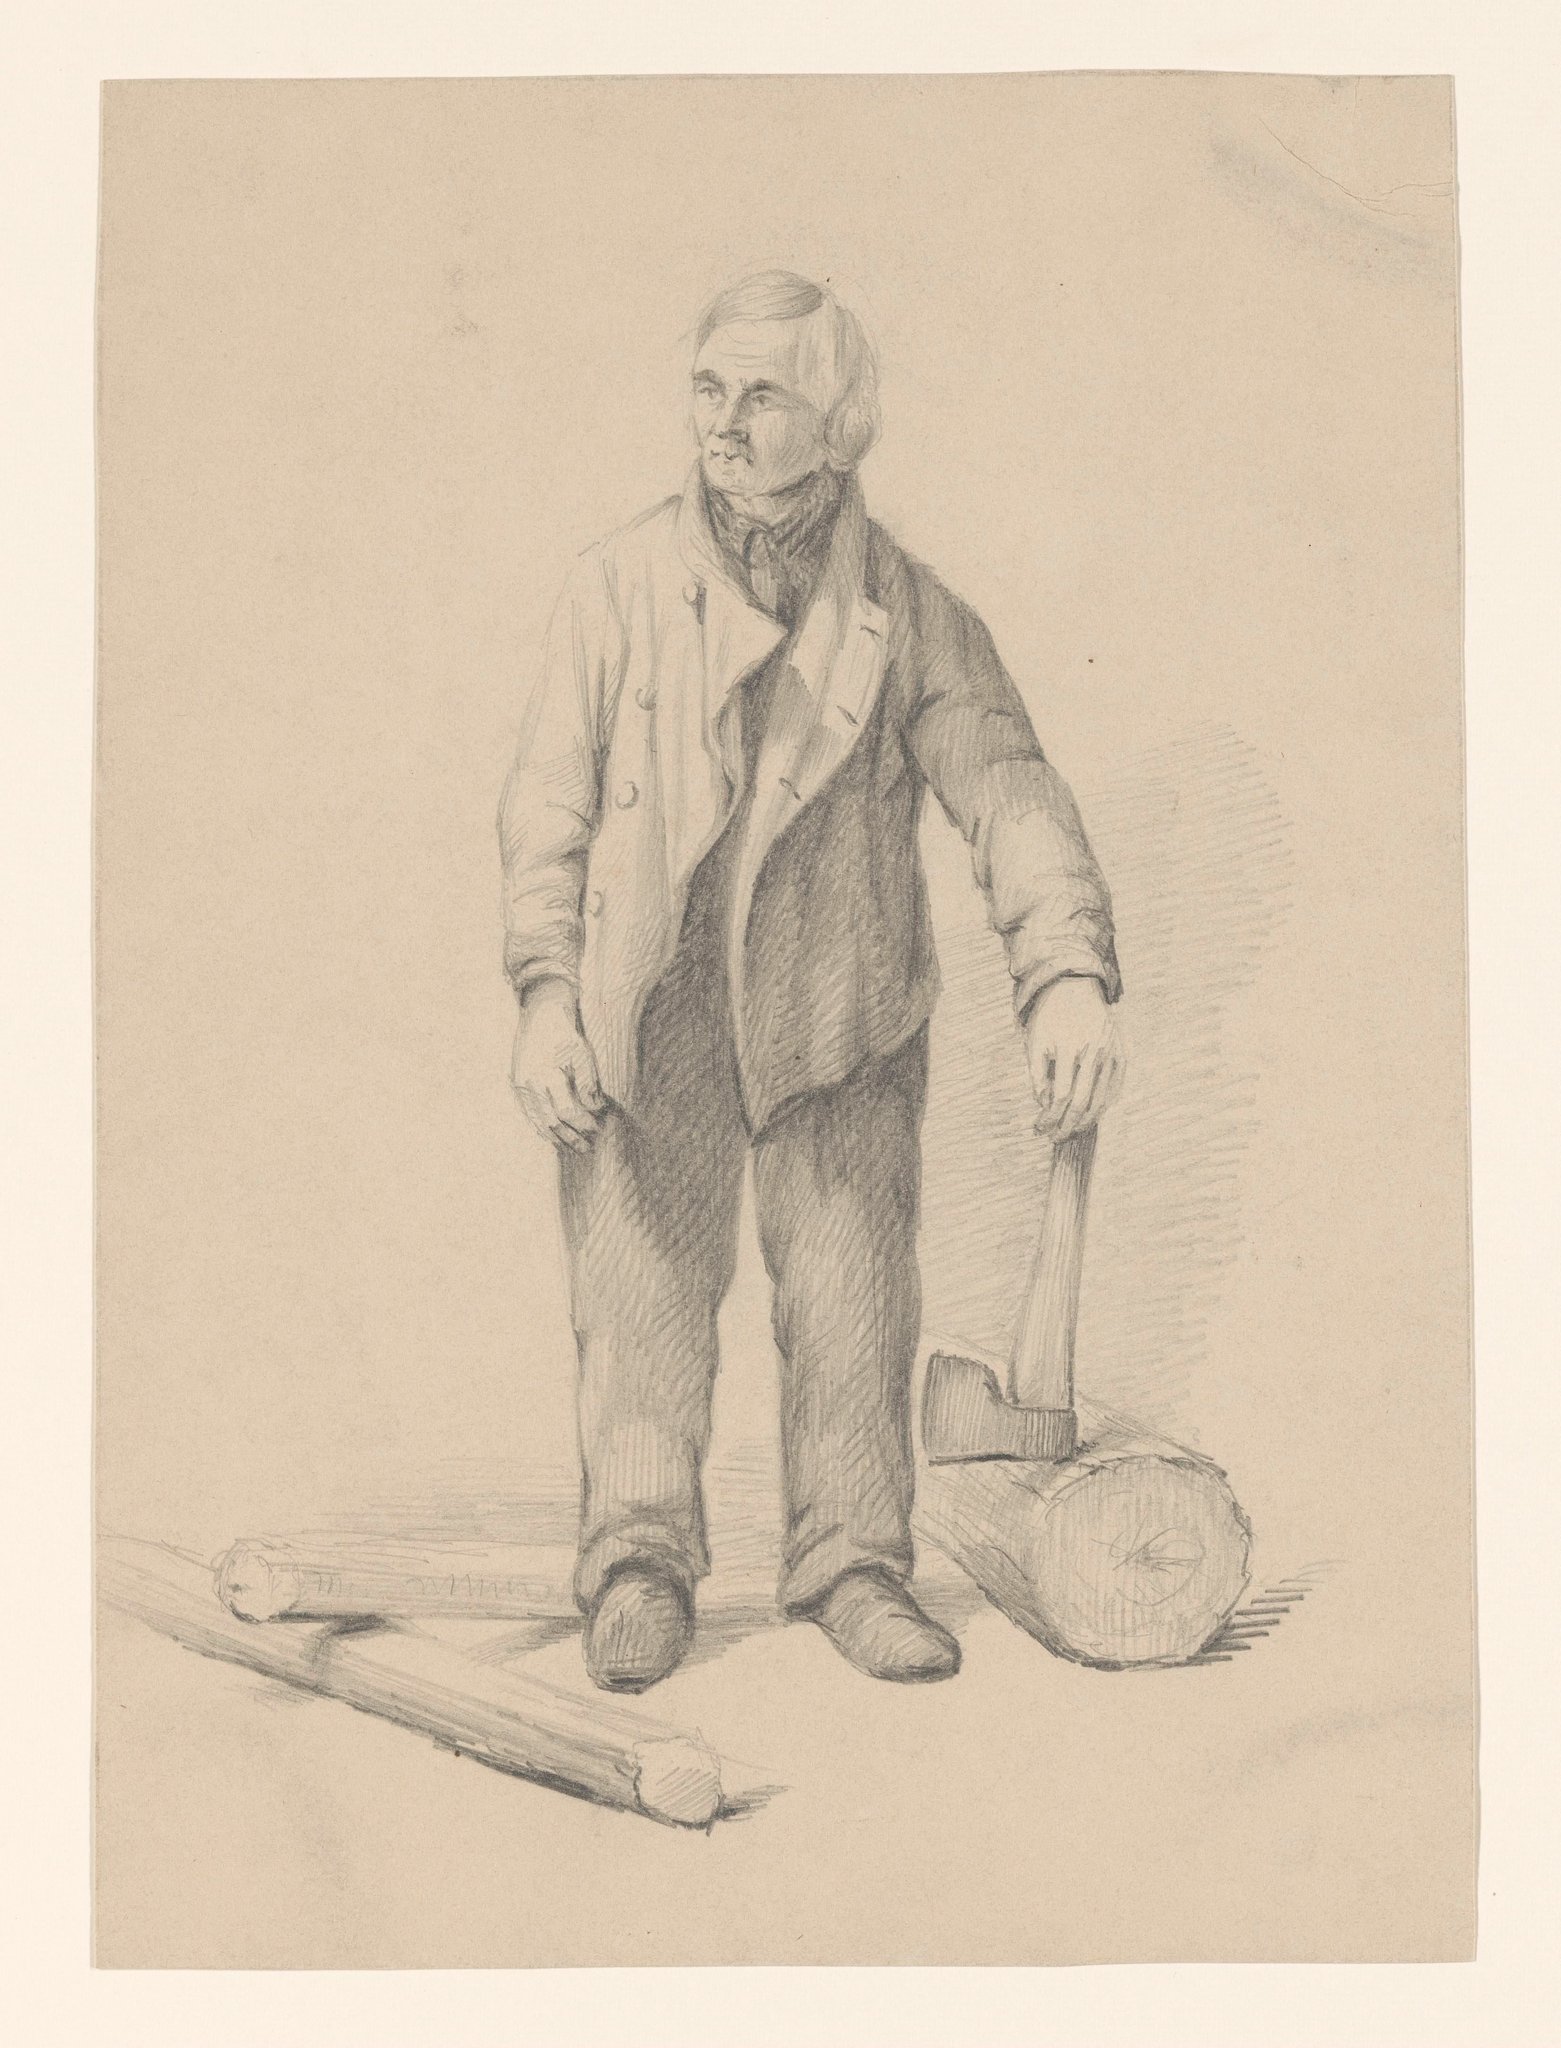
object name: drawing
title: Staande houthakker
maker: alexander cranendoncq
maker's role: draughtsman, print maker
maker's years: 1799-1869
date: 1809-1869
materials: paper, pencil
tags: woodcutting, woodcutter ~ forestry